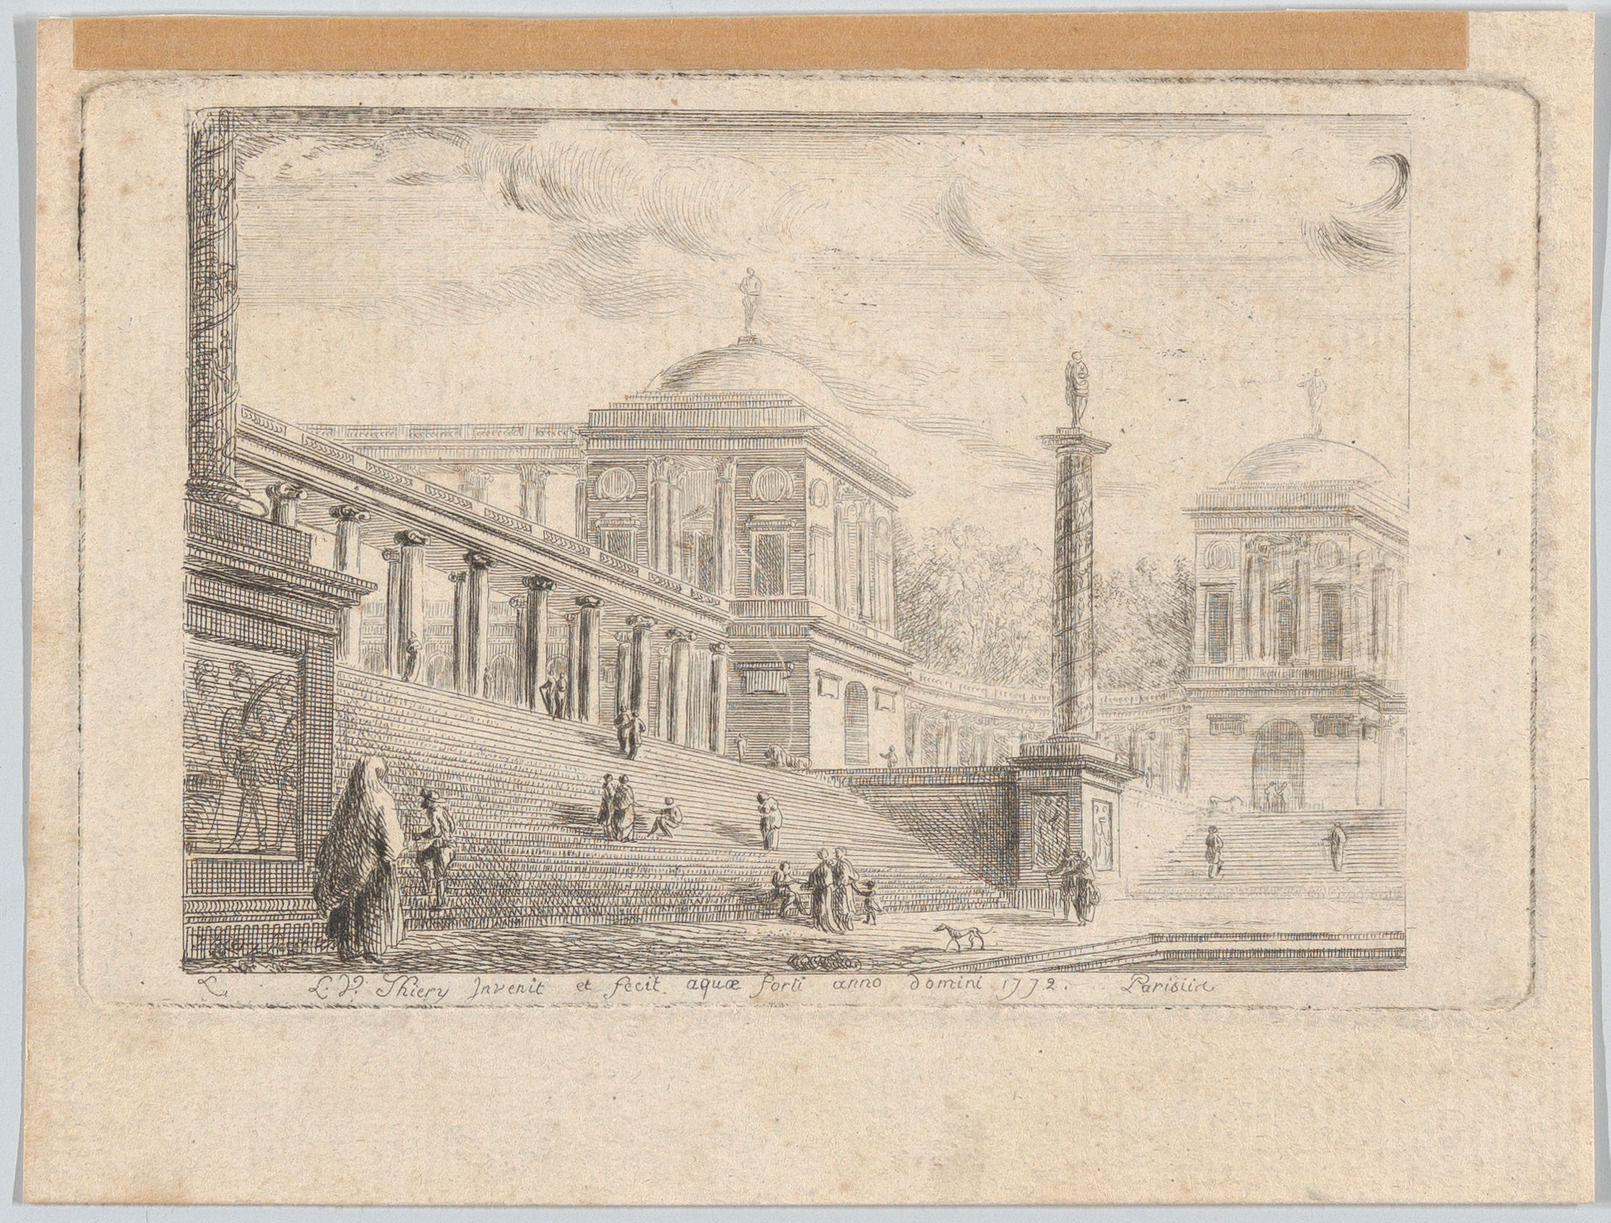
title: An Architectural Capriccio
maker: luc vincent thiery de sainte colombe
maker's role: artist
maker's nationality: french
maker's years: 1734-1812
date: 1772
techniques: etching